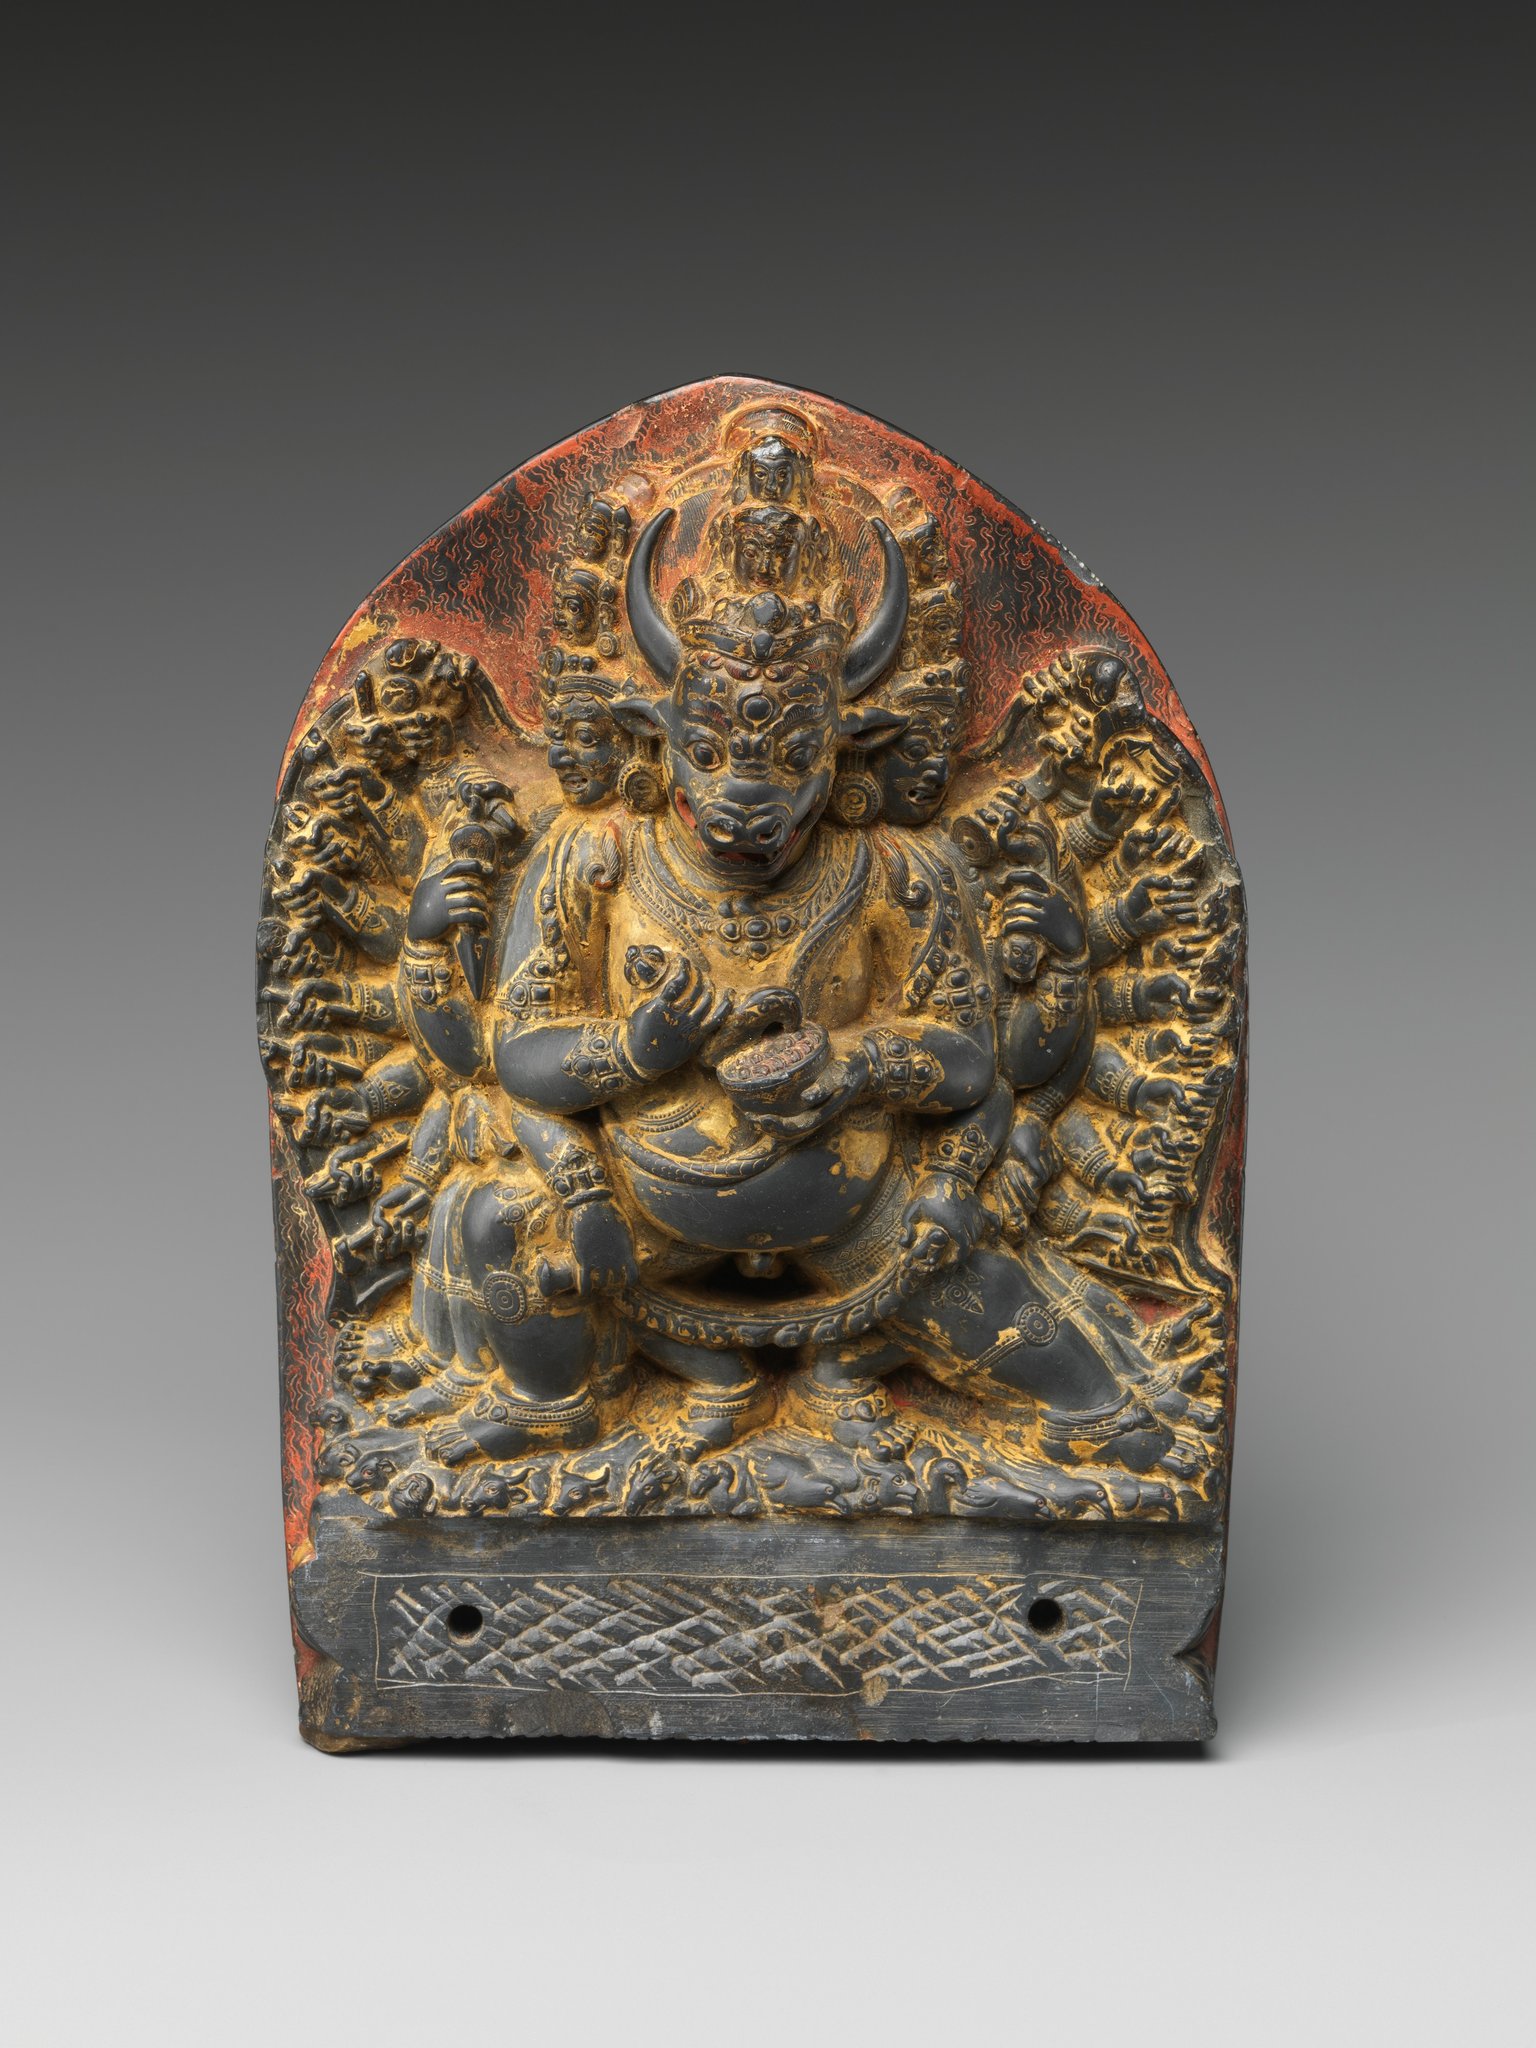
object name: stele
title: Vajrabhairava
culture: tibetan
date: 1401-1500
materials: stone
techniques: polychromy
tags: buddhism,deities